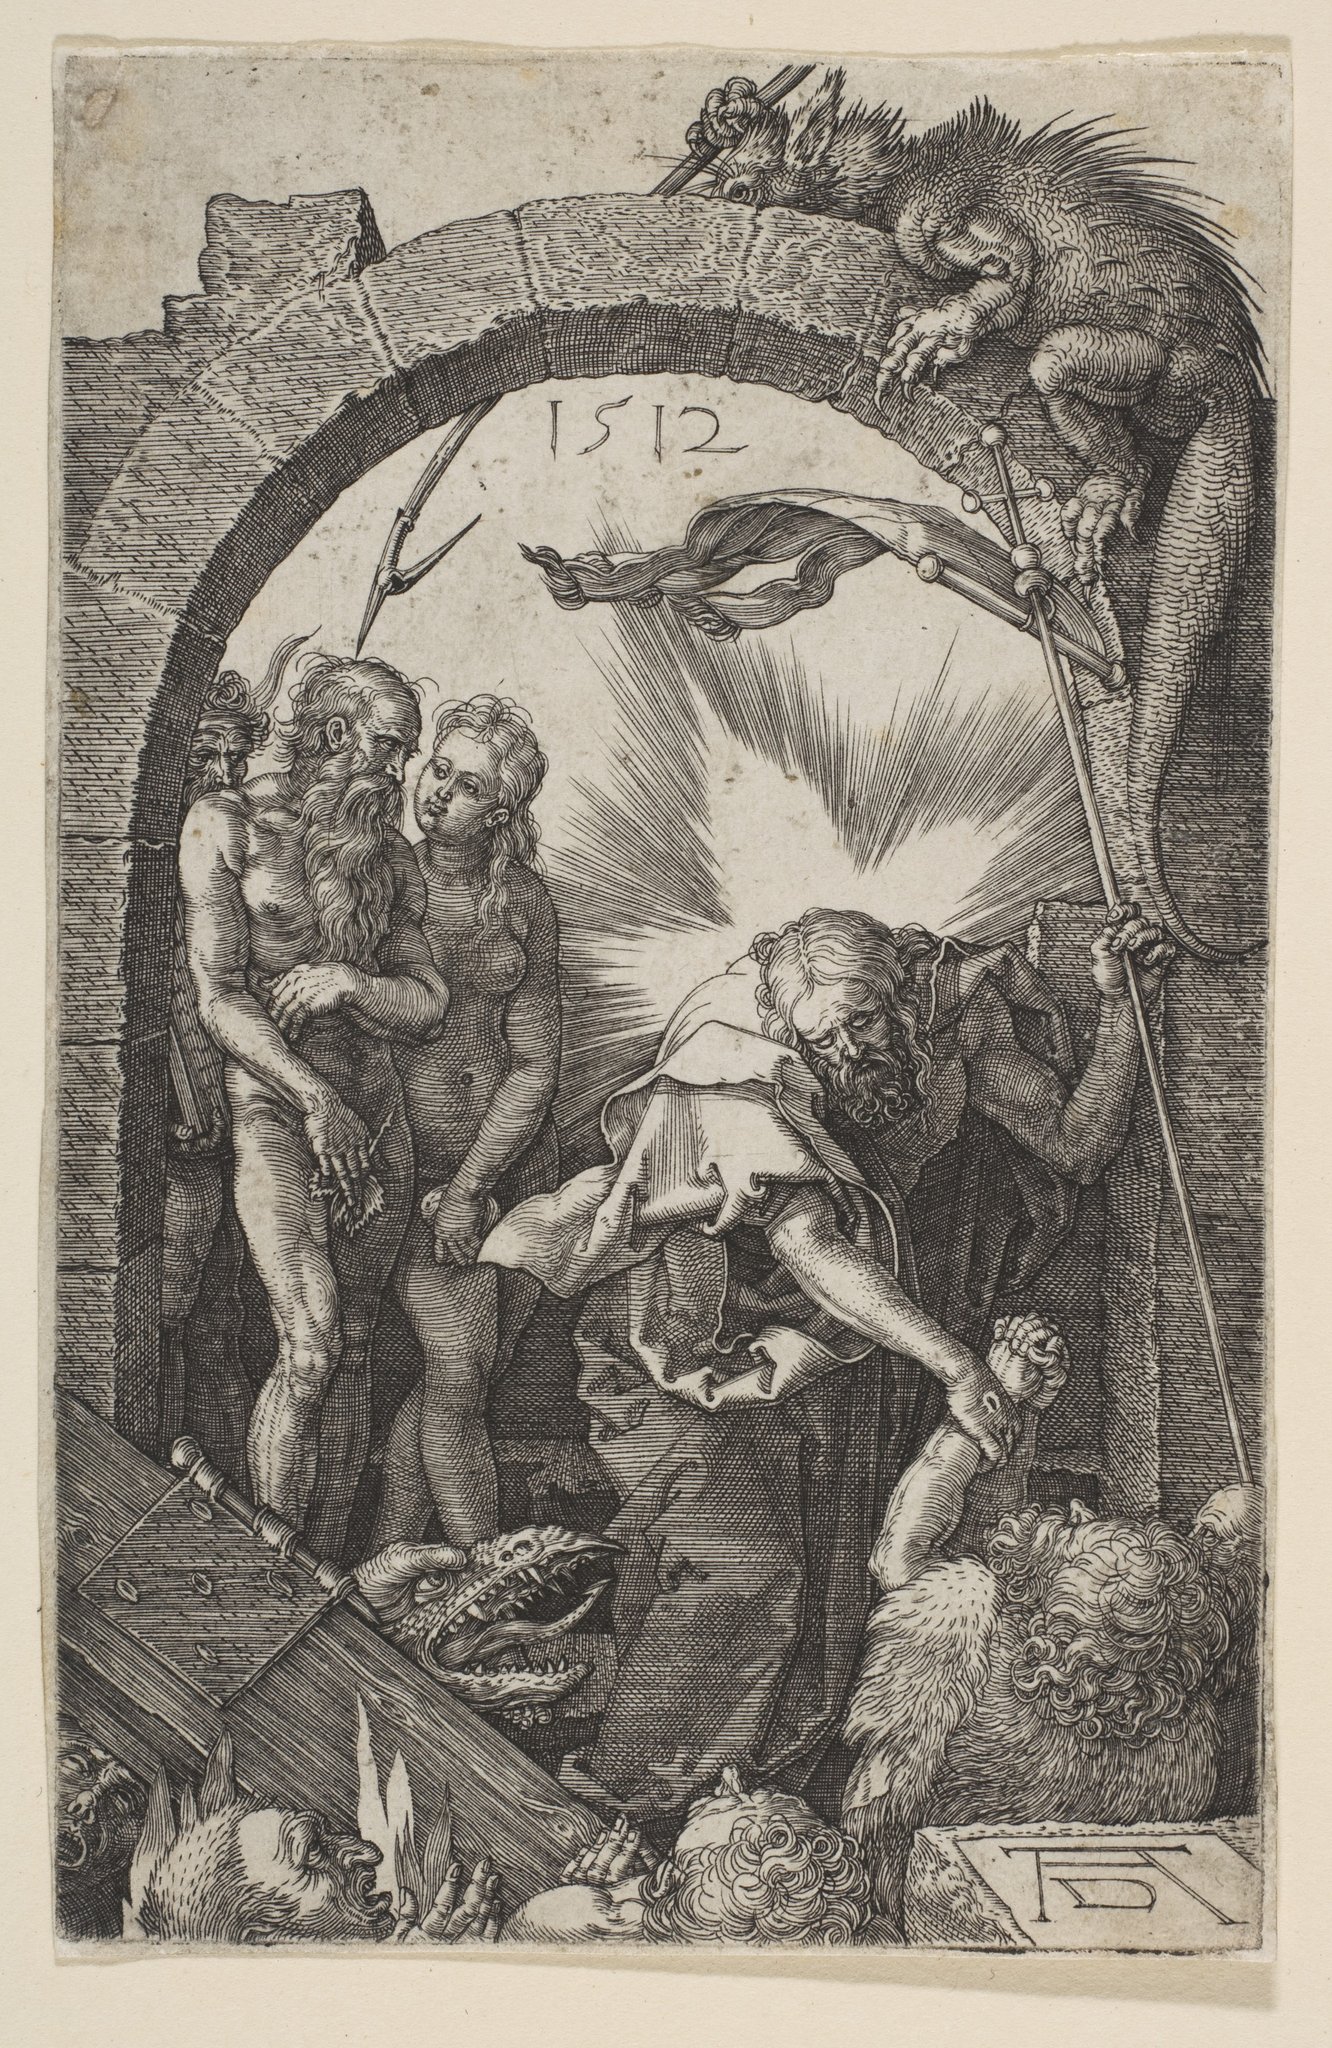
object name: print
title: Christ in Limbo, from "The Passion"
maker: albrecht dürer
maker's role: artist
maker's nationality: german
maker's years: 1471-1528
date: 1512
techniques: engraving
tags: male nudes,female nudes,jesus